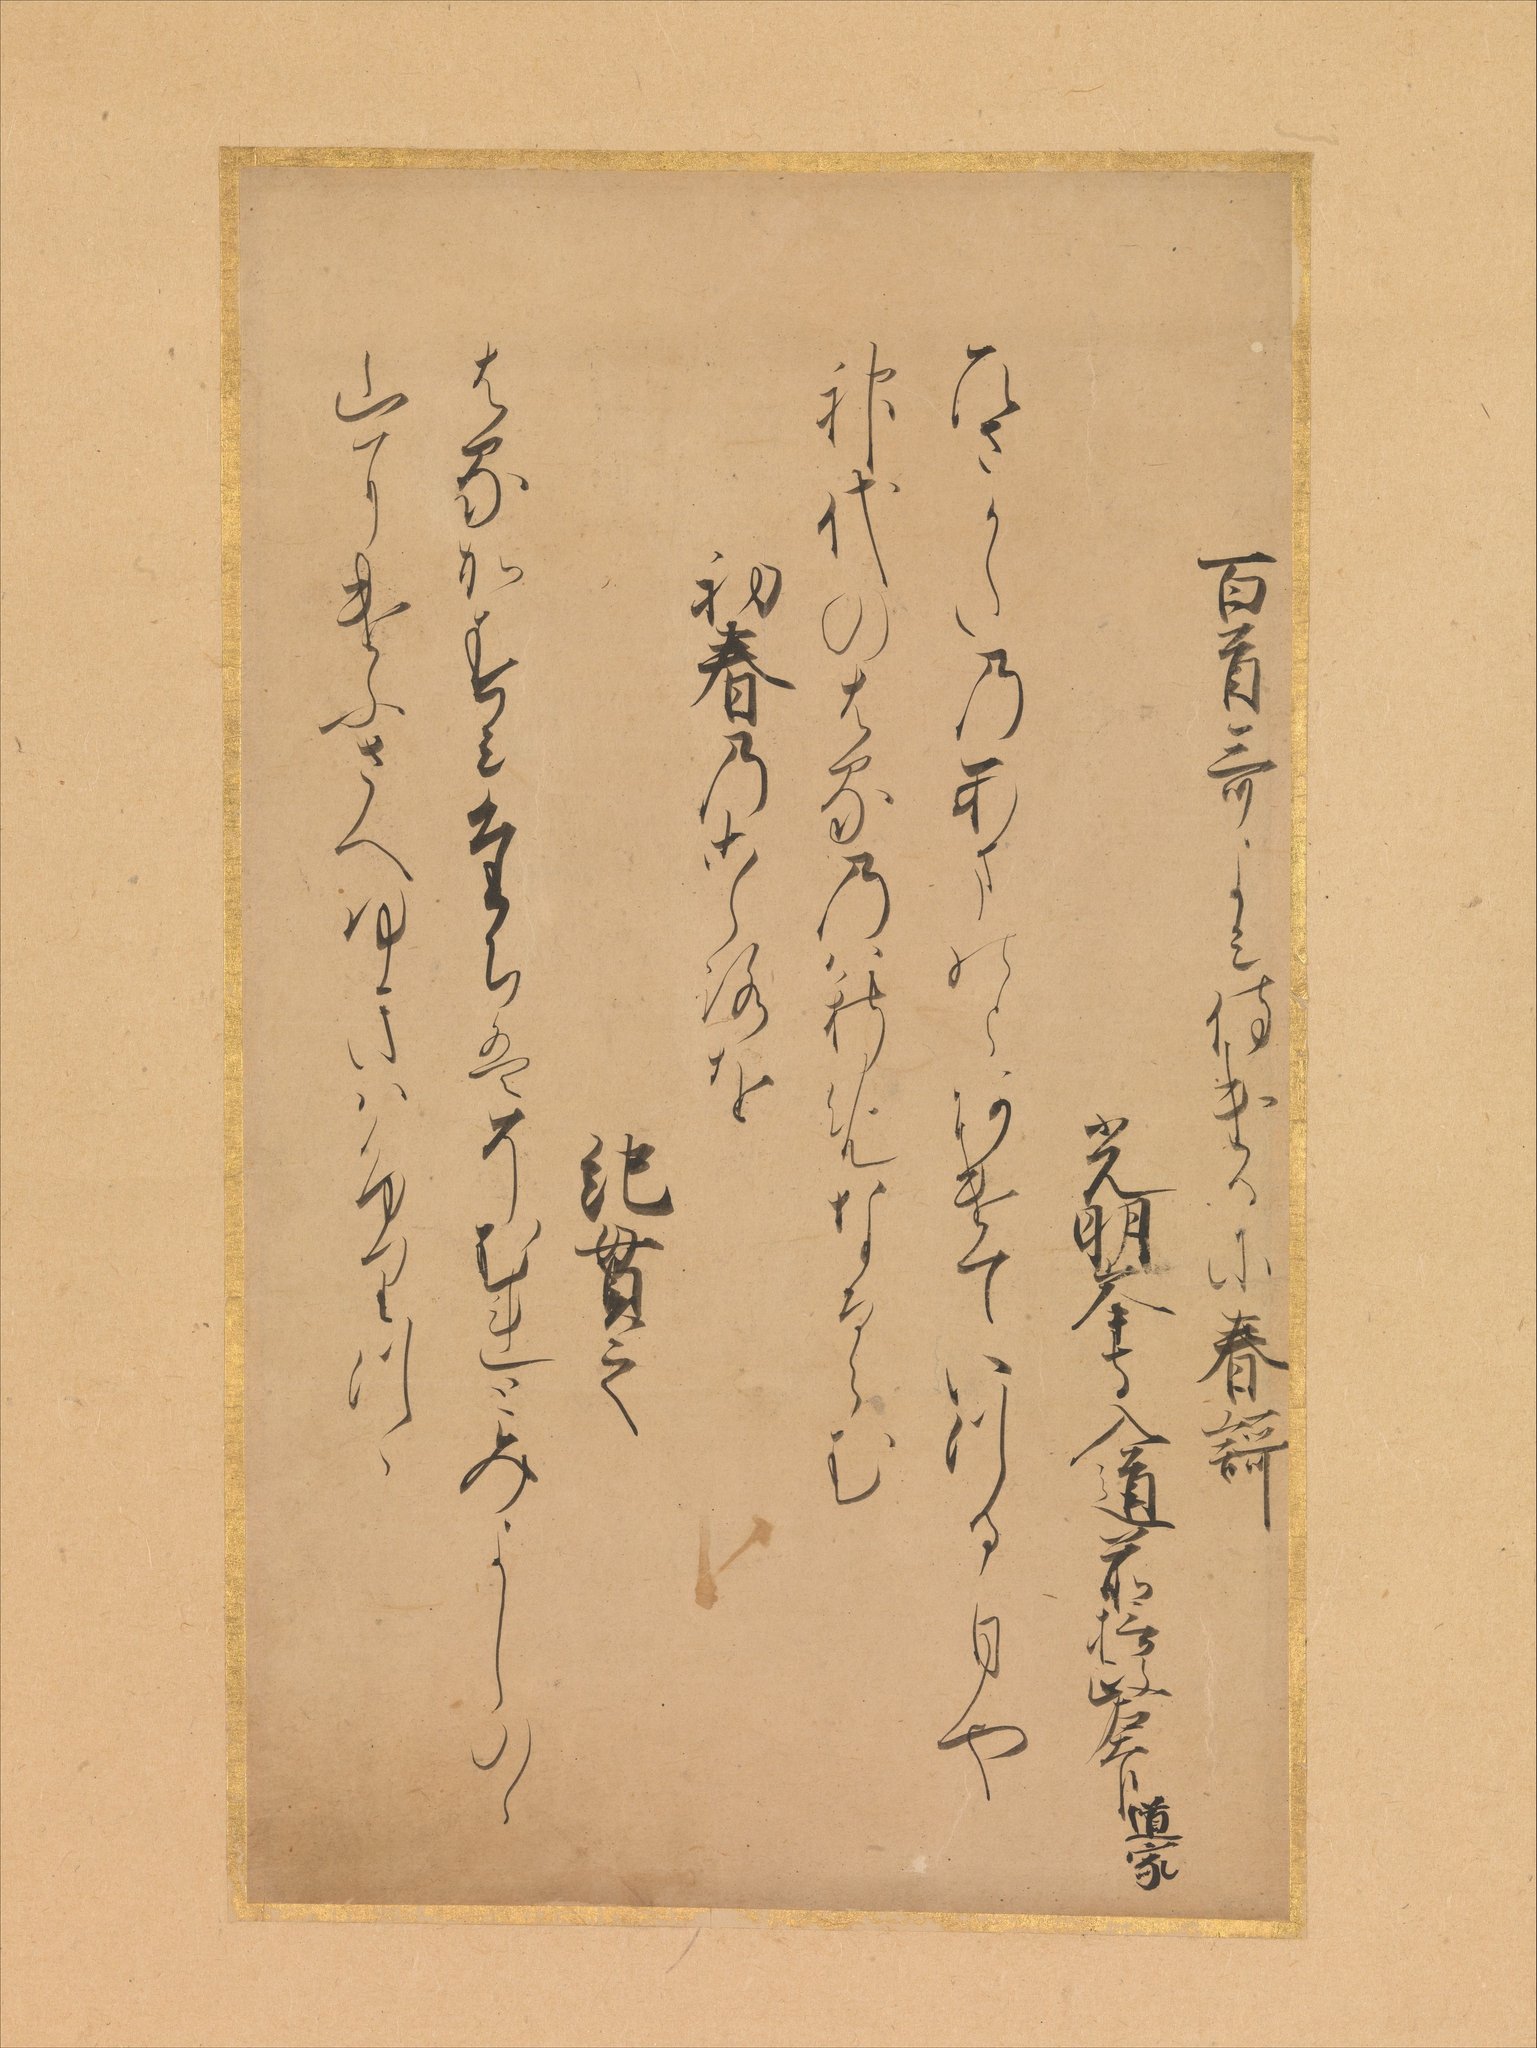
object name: hanging scroll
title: Two Poems from the Collection of Poems Ancient and Modern, Continued (Zoku Kokin wakashū)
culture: japanese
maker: nun abutsu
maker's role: artist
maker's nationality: japanese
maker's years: -1283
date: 1201-1300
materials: ink, paper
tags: poetry,scrolls